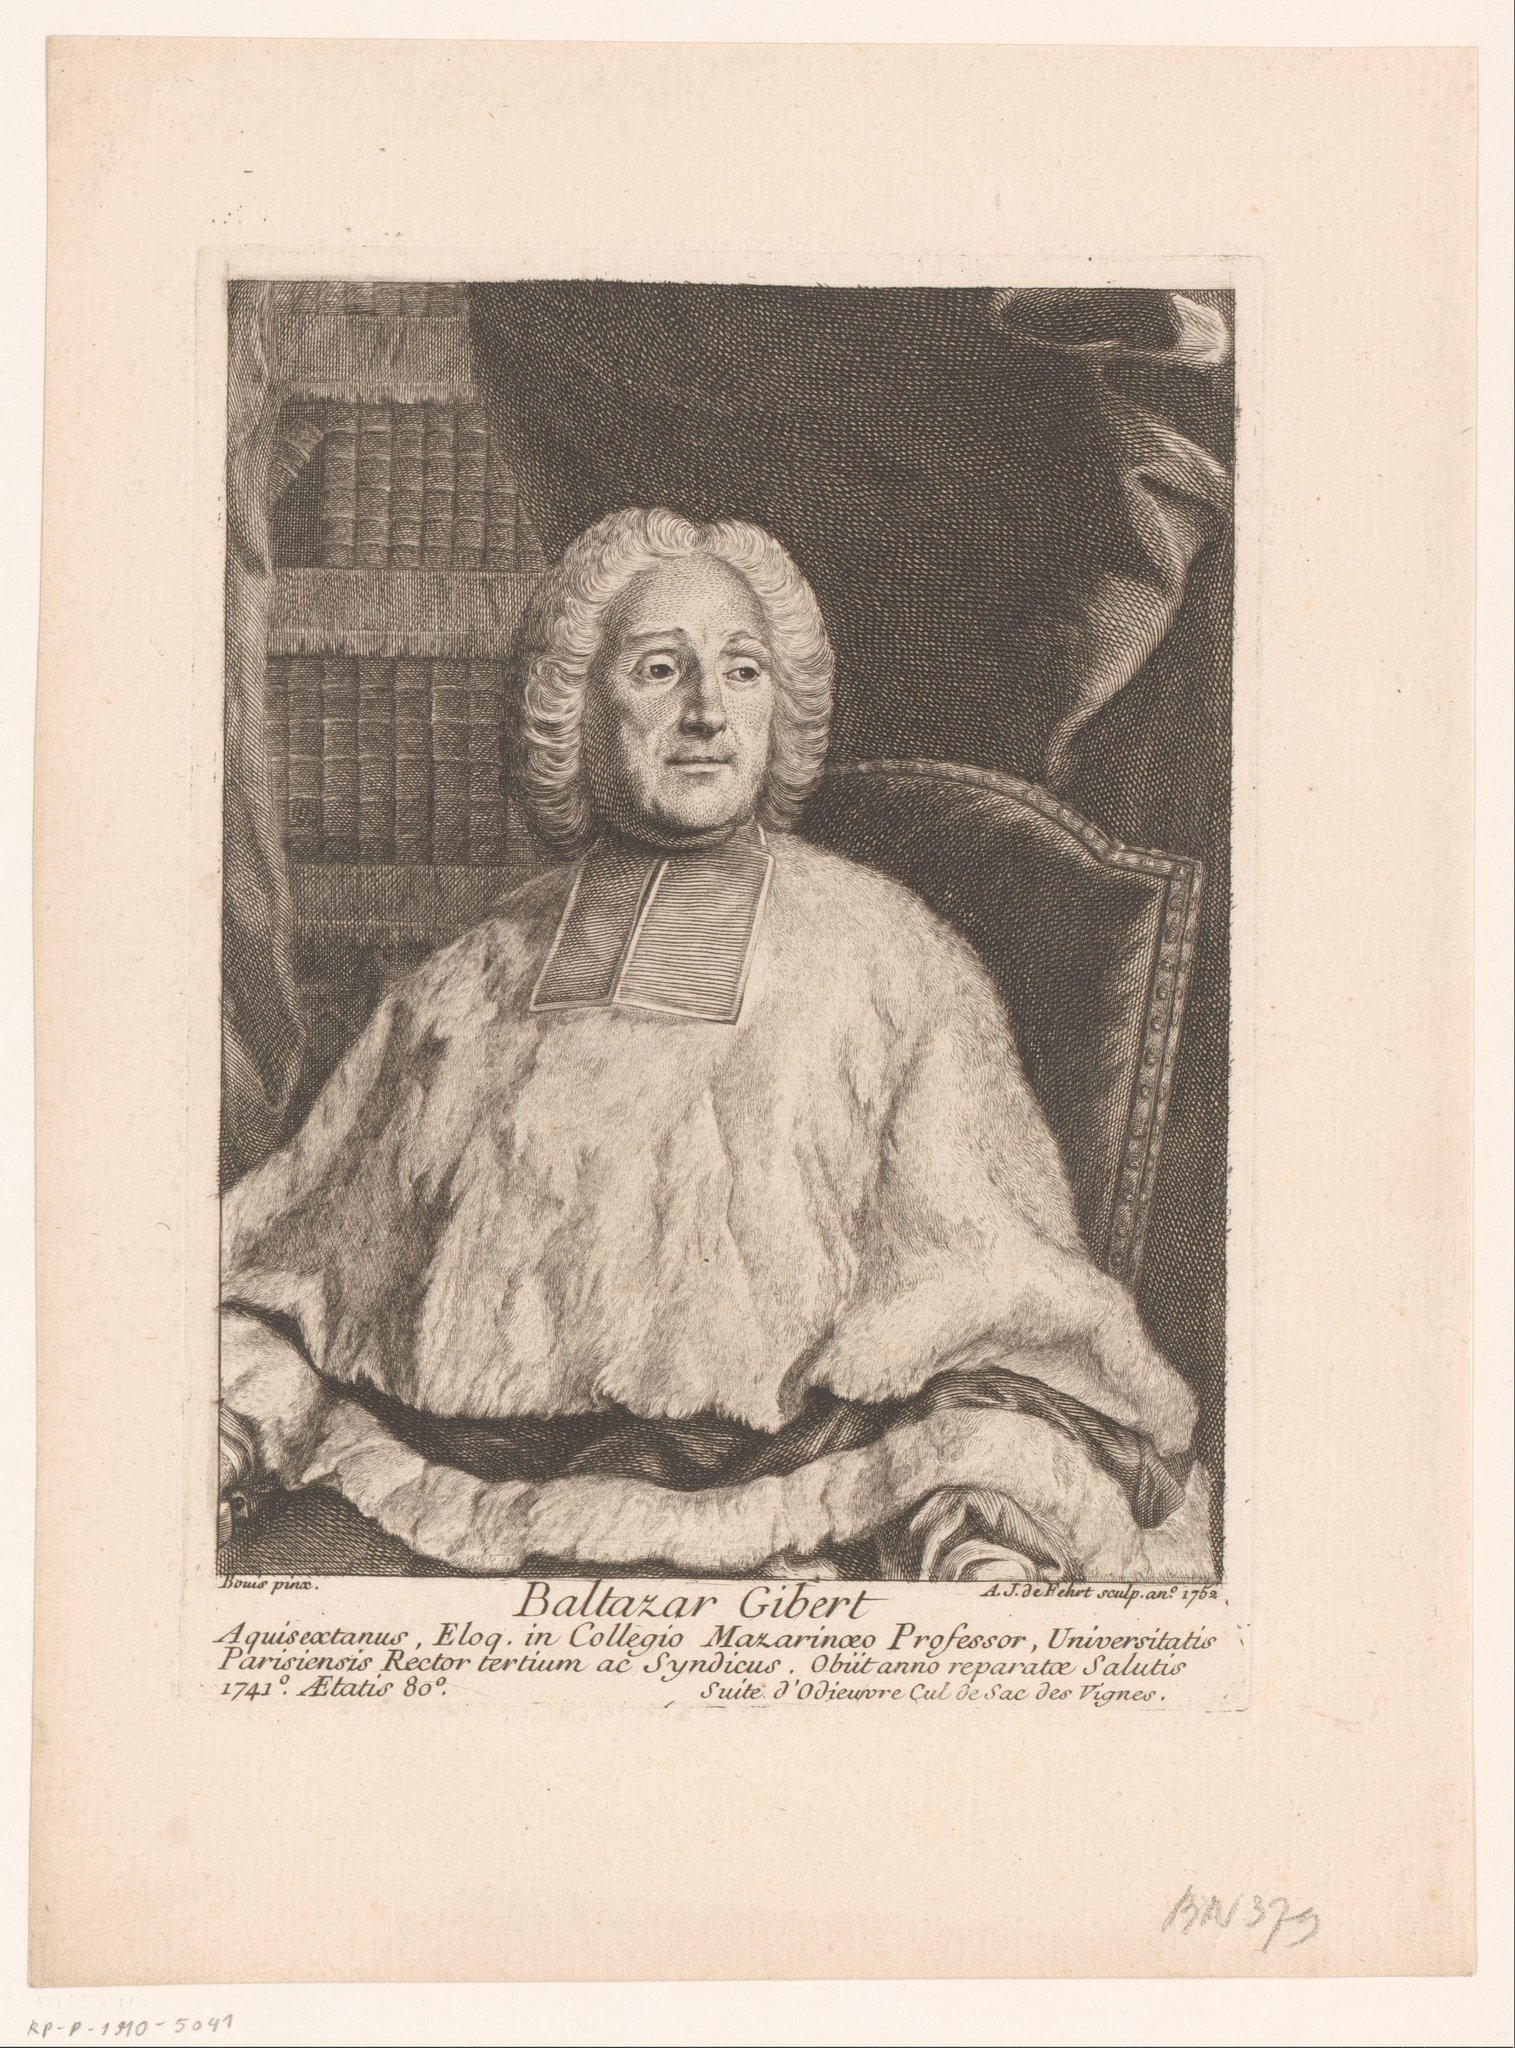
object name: print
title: Baltazar Gibert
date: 1752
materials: paper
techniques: engraving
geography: france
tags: bookshelves, historical persons, portrait of a writer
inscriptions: collector's mark: Lugt 2228